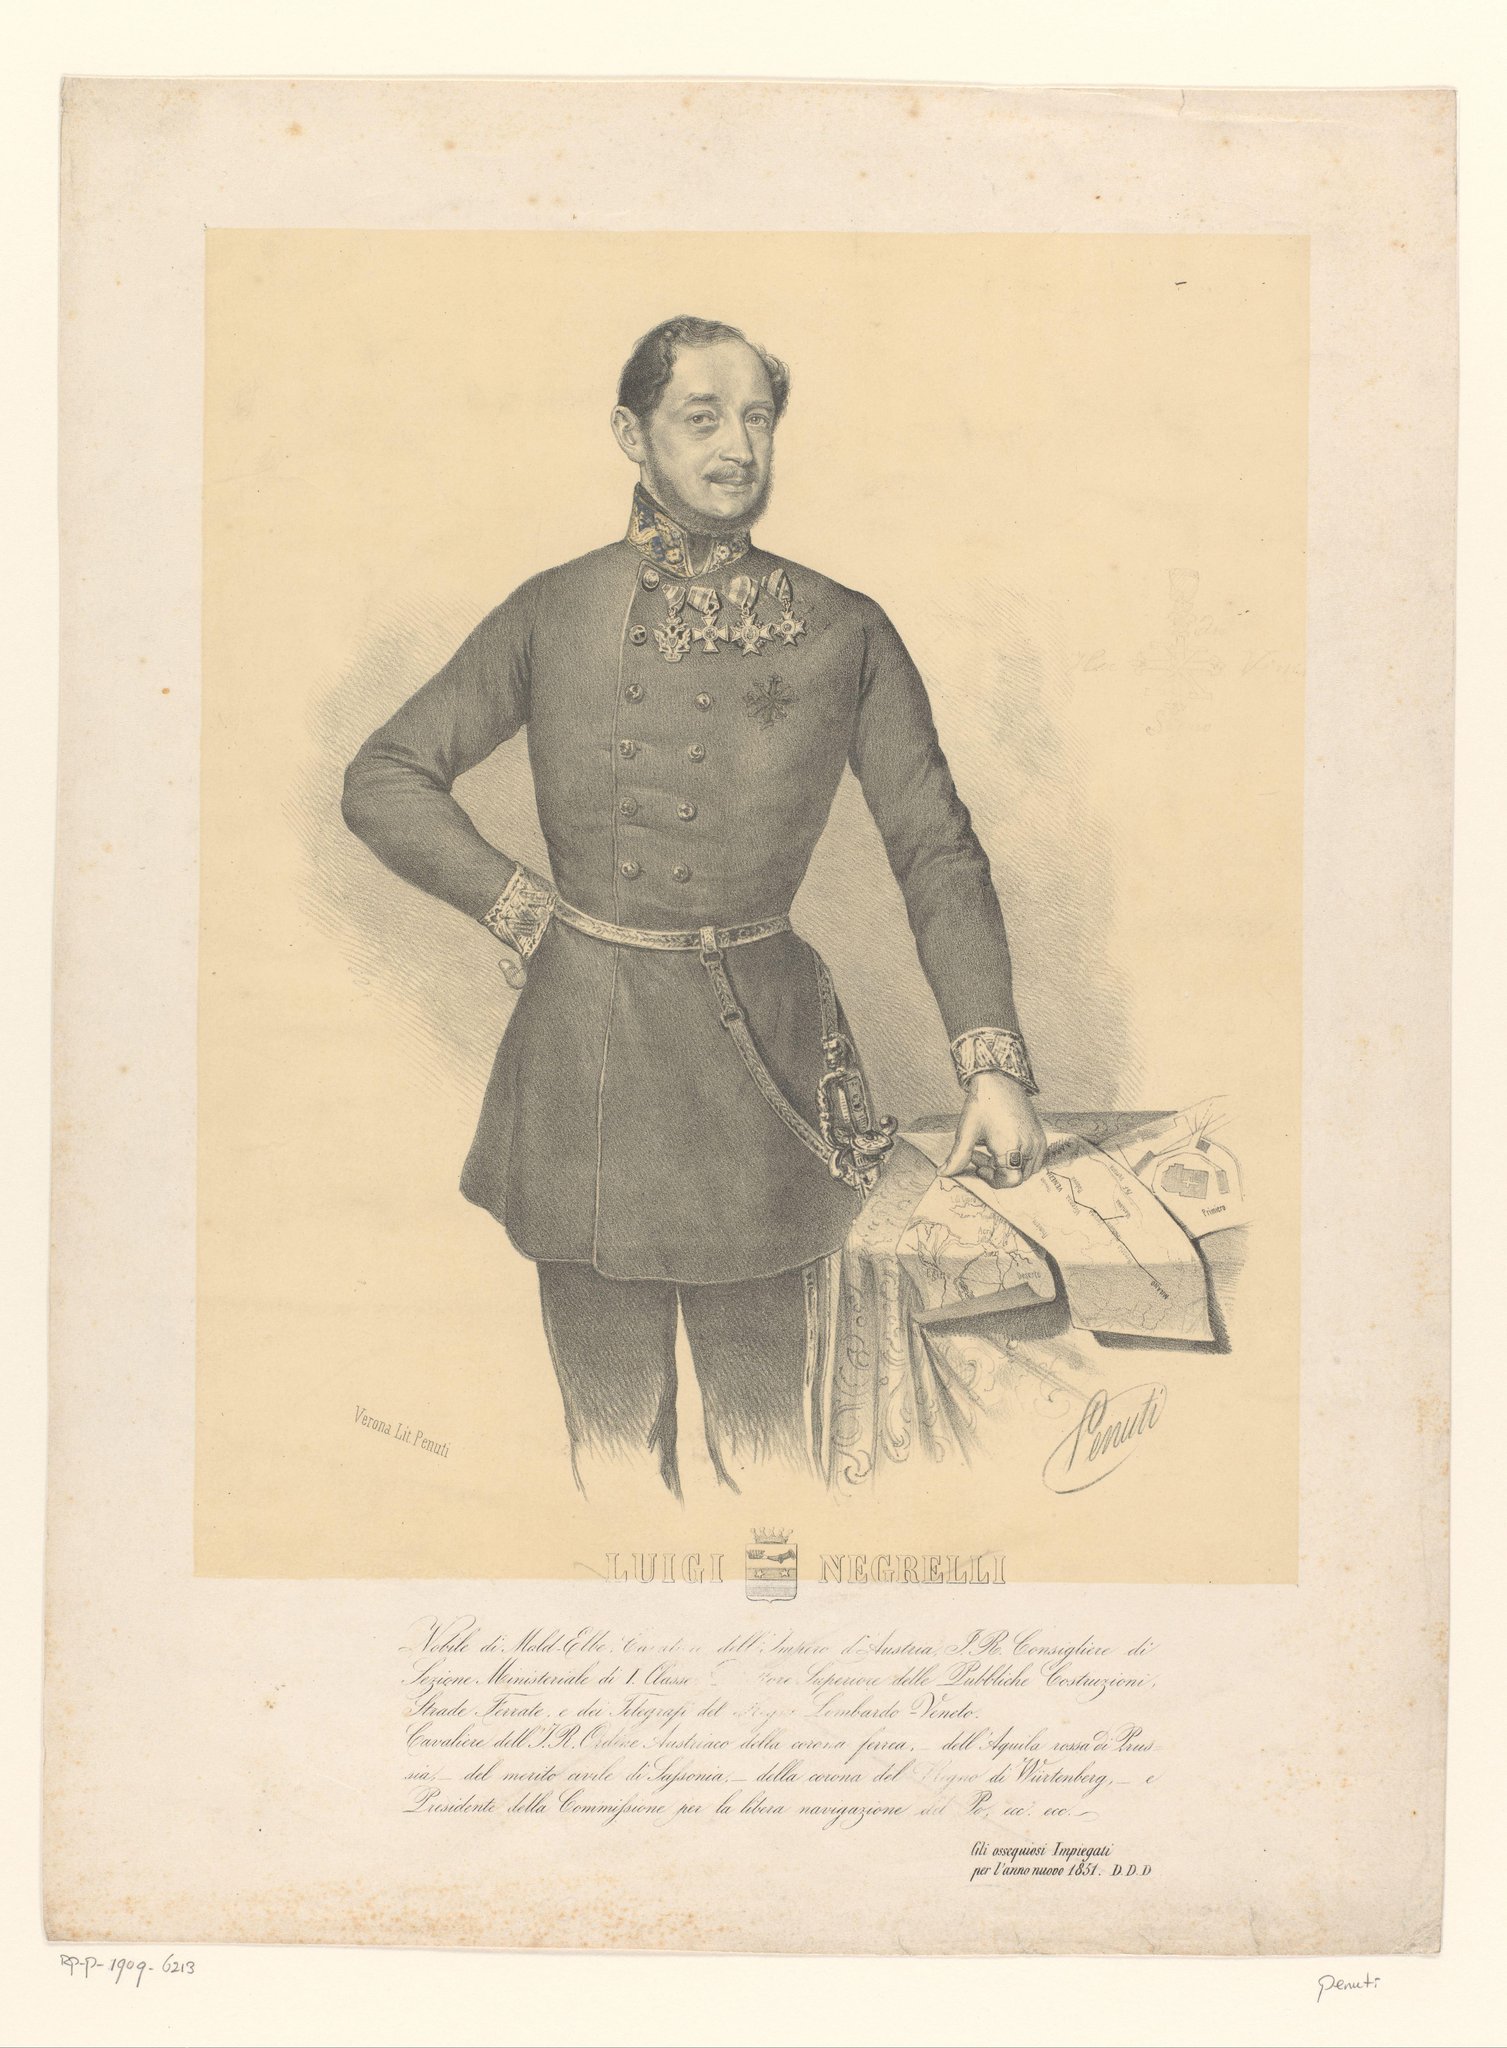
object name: print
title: Portret van ingenieur Luigi Negrelli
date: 1851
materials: paper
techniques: lithograph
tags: engineer, historical persons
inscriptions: collector's mark: Lugt 2228